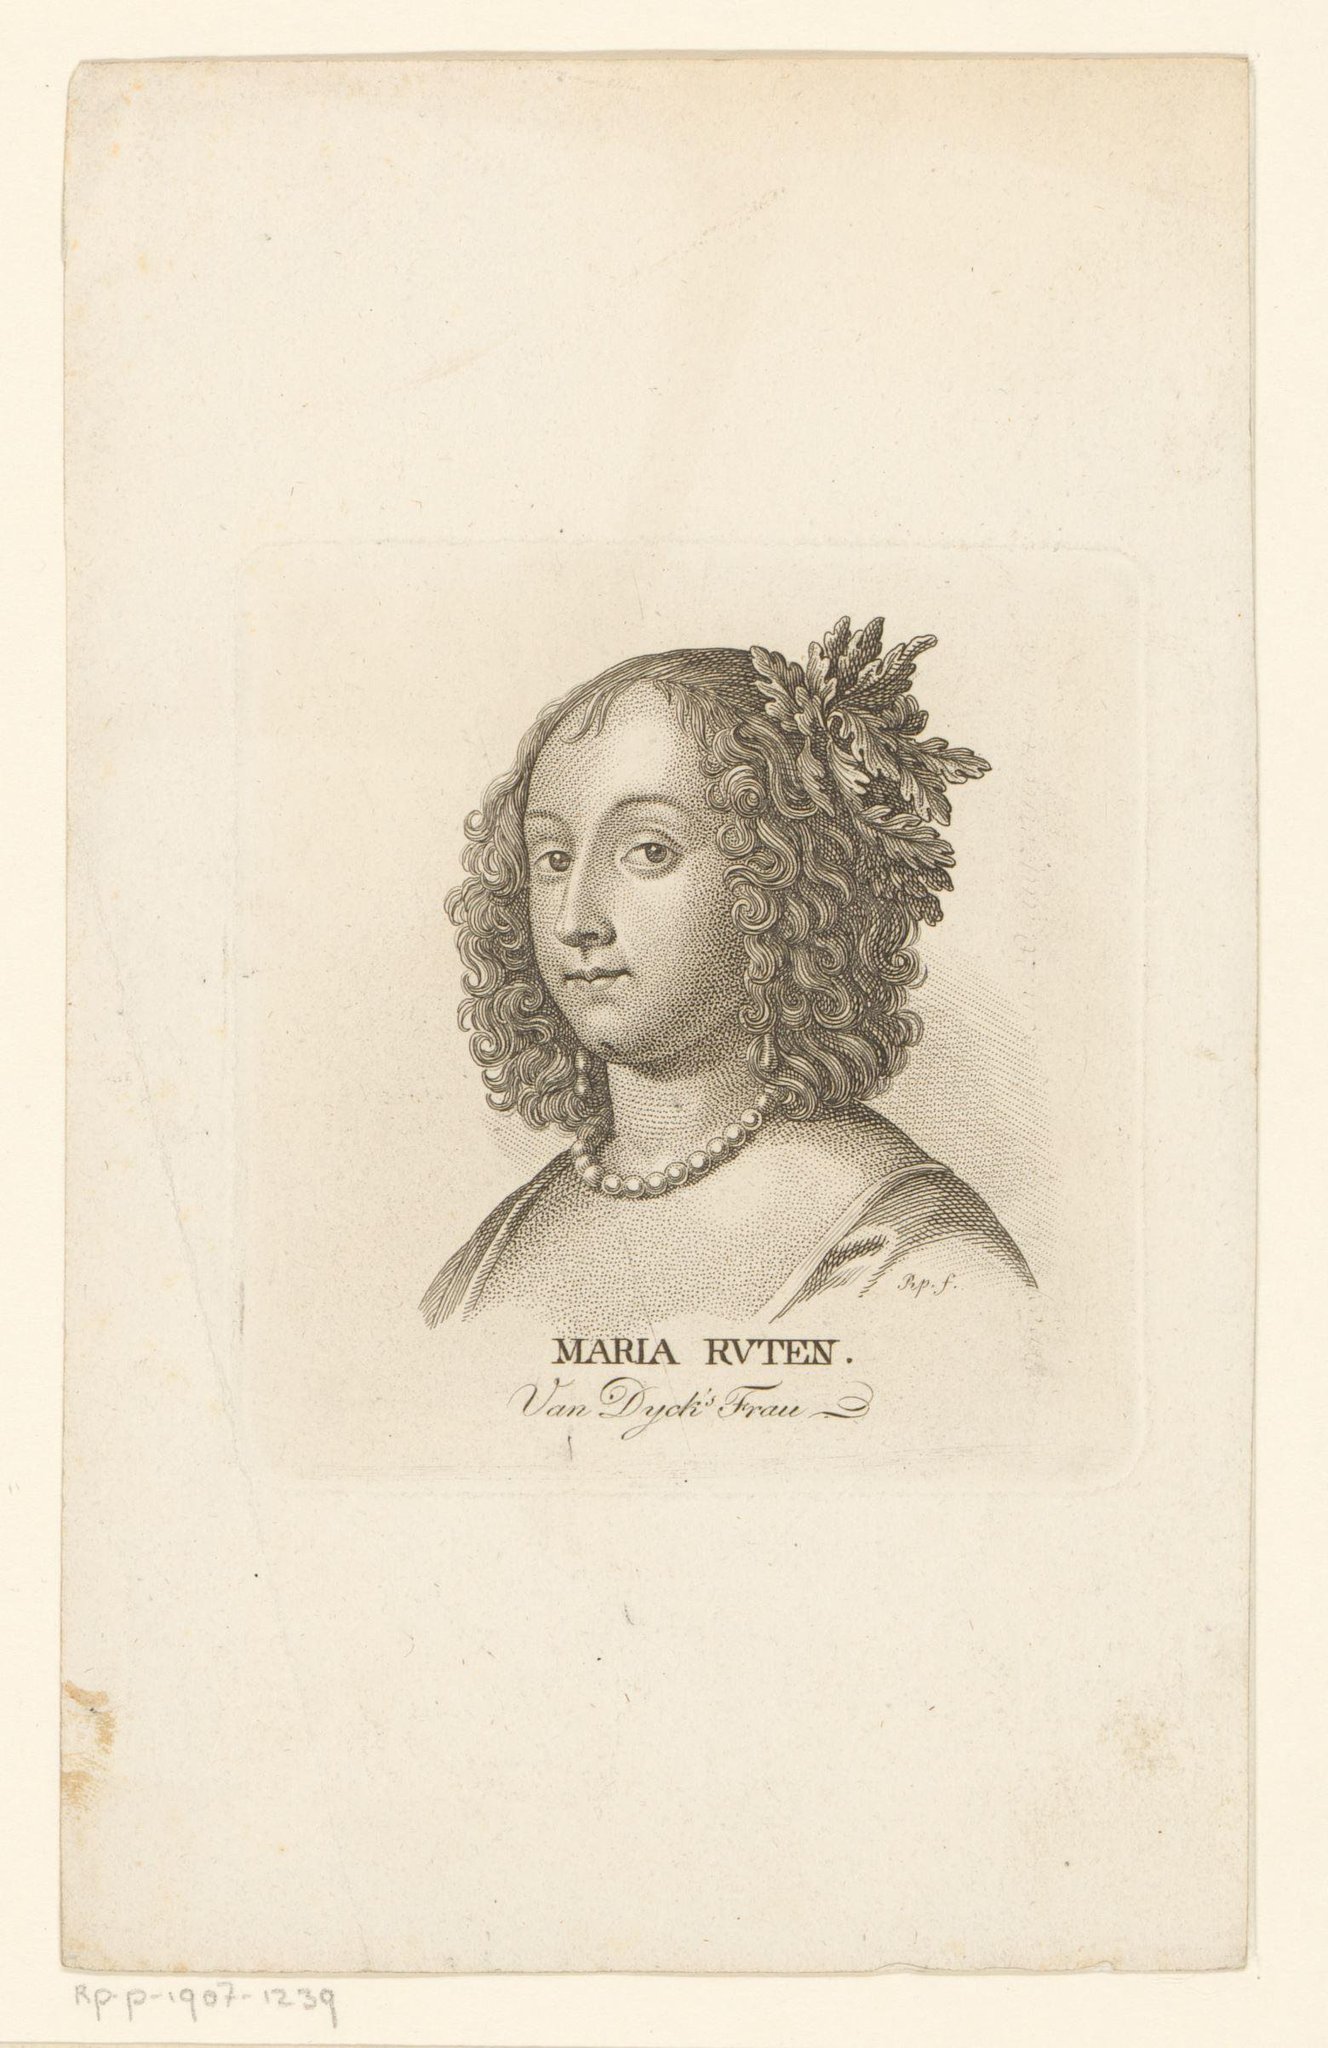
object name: print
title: Portret van Maria Ruten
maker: ernst ludwig riepenhausen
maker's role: print maker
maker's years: 1765-1840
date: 1775-1840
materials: paper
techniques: engraving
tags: historical persons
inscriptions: collector's mark: Lugt 2228